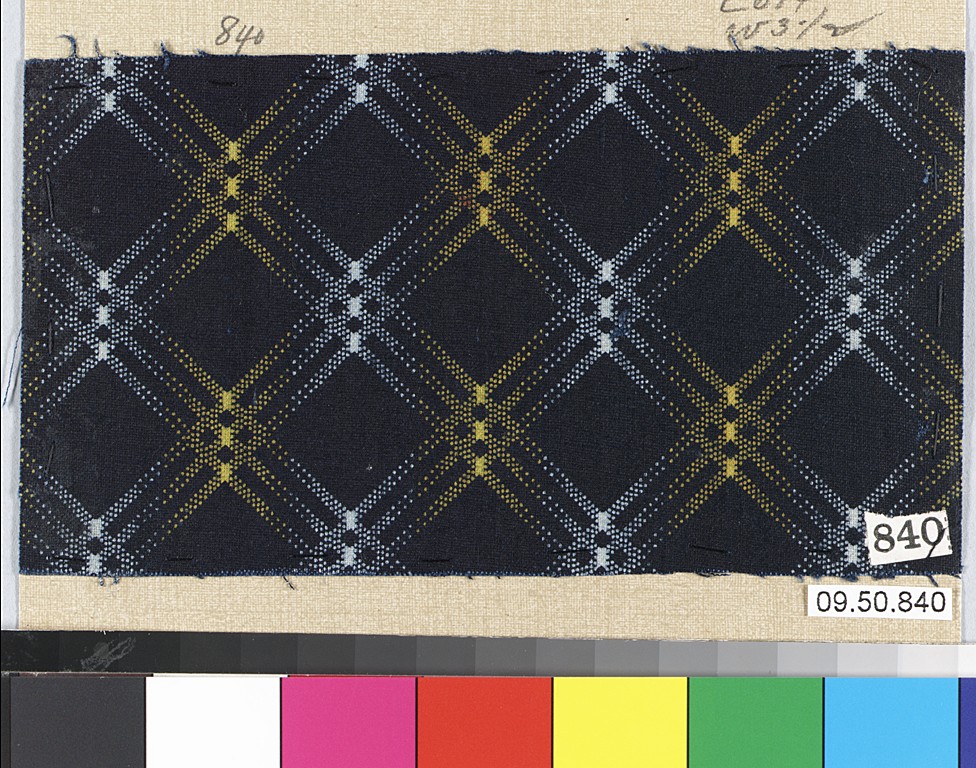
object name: piece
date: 1801-1900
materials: cotton